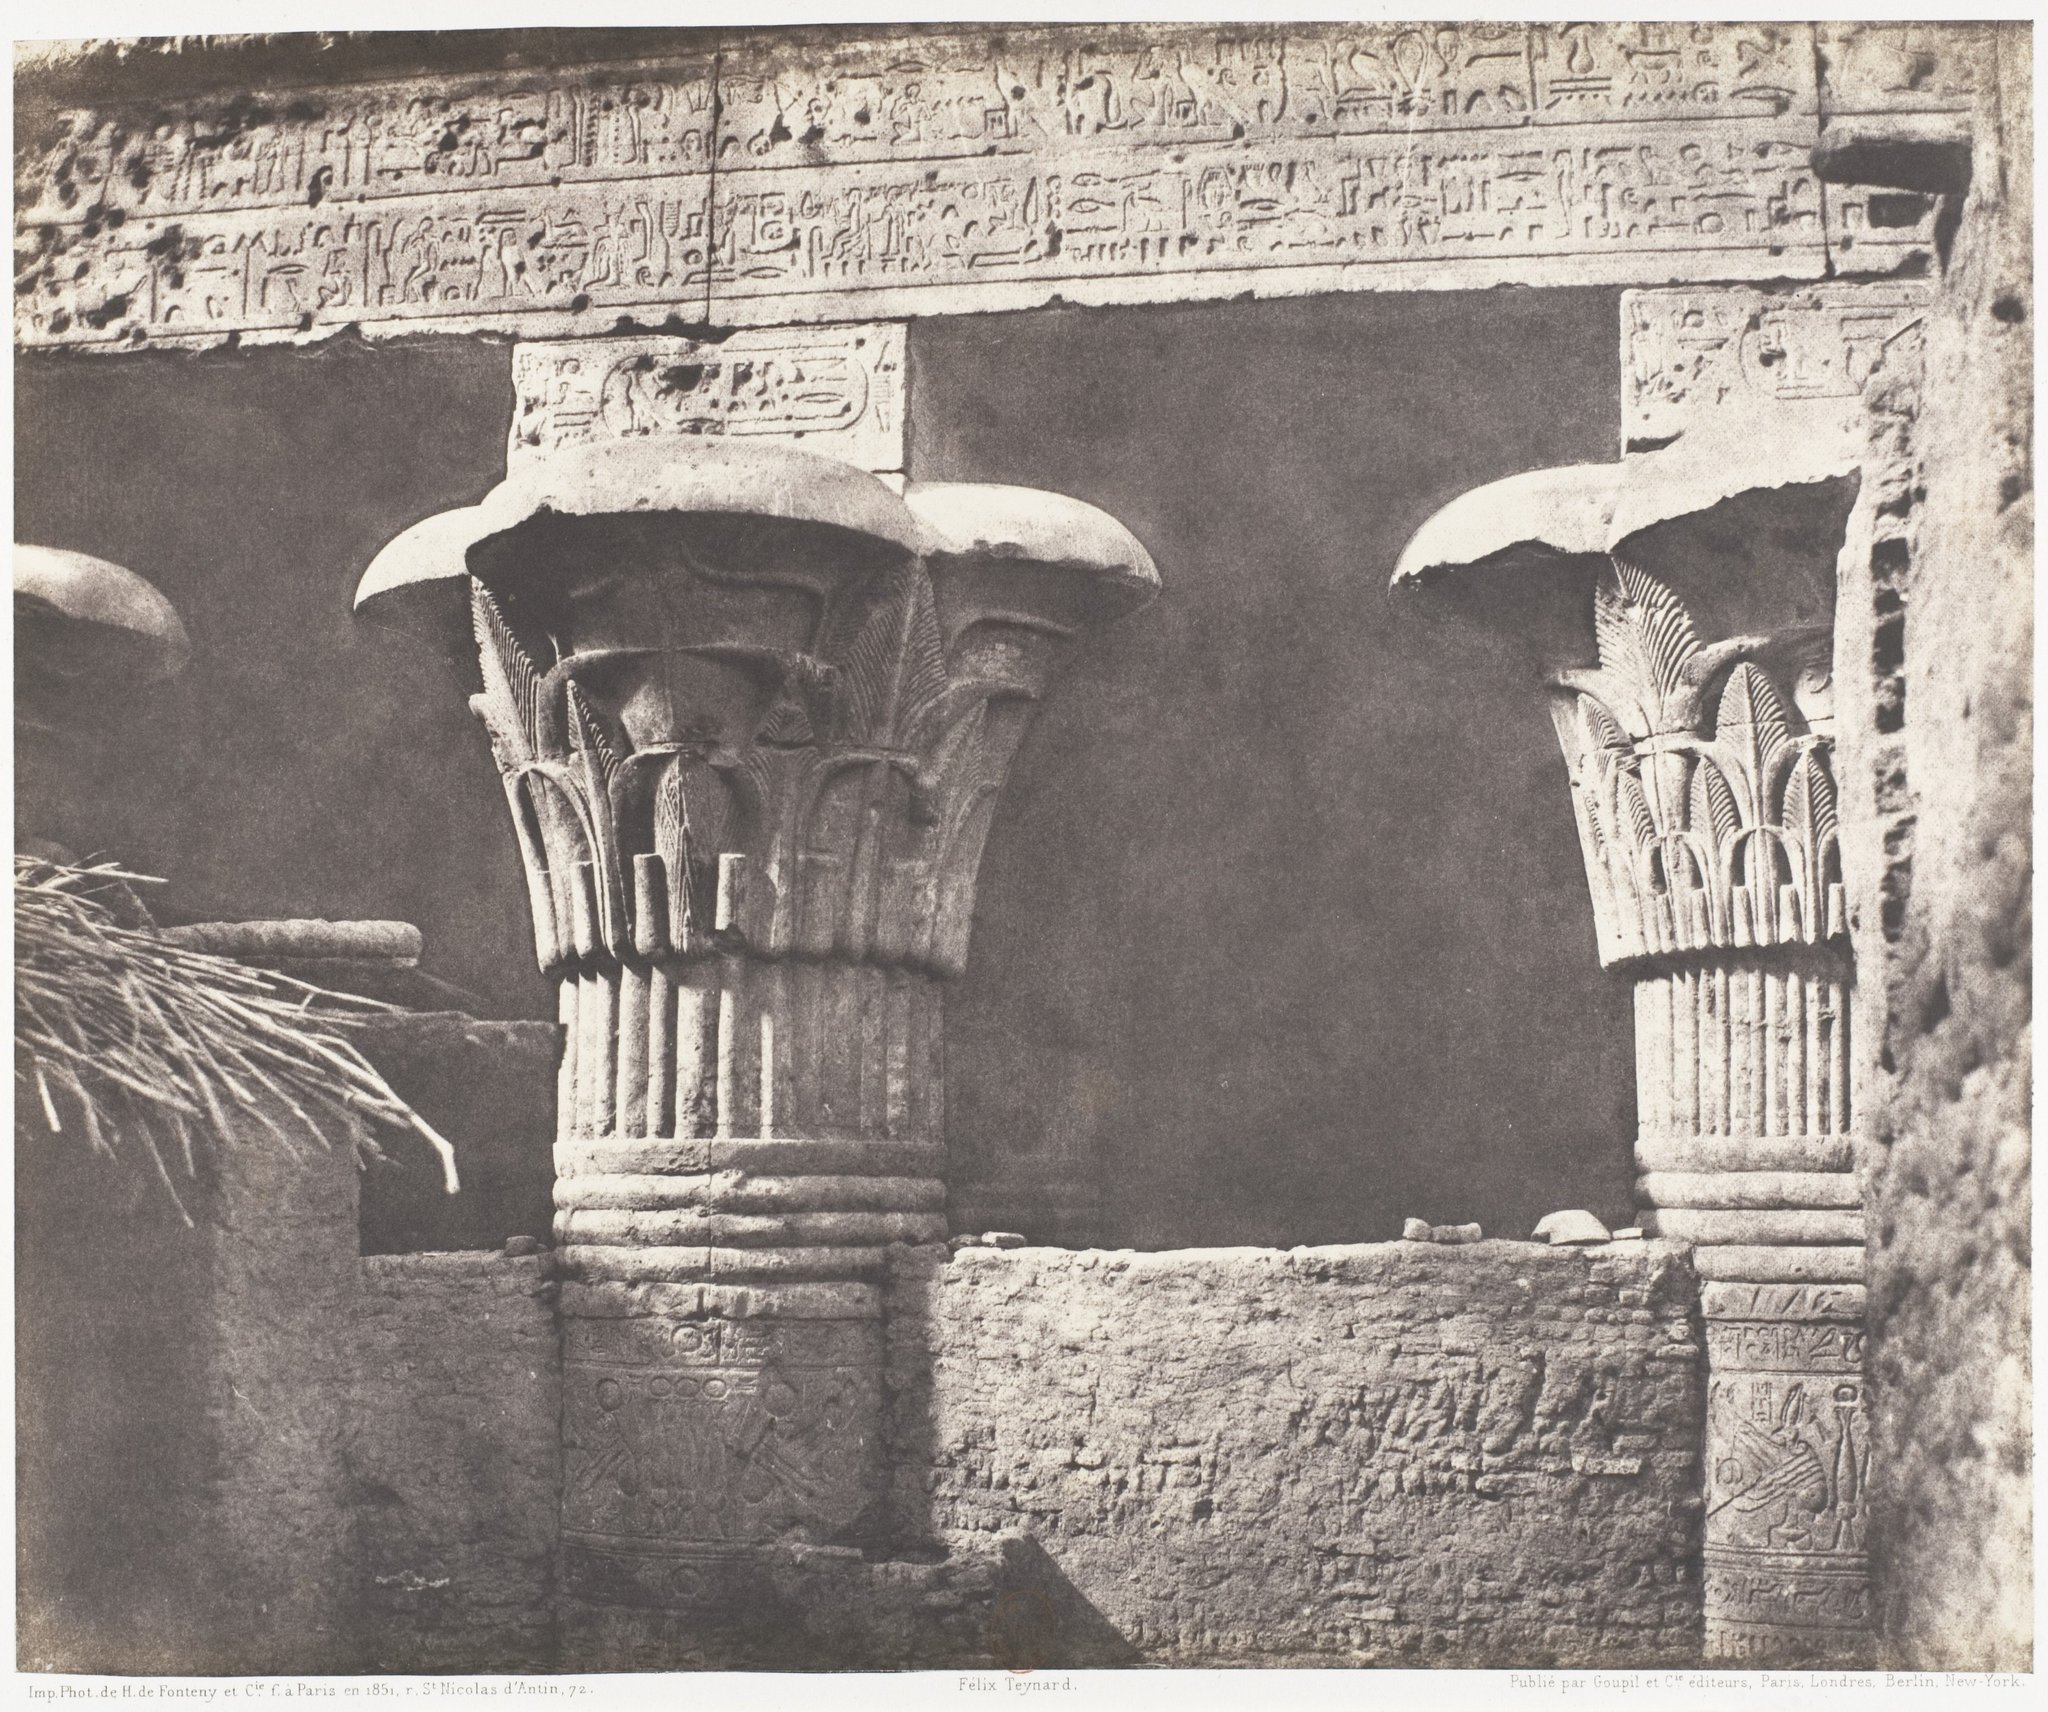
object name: photograph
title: Esneh (Latopolis), Construction Ensablée - Architrave, Futs, et Chapiteaux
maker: félix teynard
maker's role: artist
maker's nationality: french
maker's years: 1817-1892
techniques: paper negative, salted paper print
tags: architecture,ruins